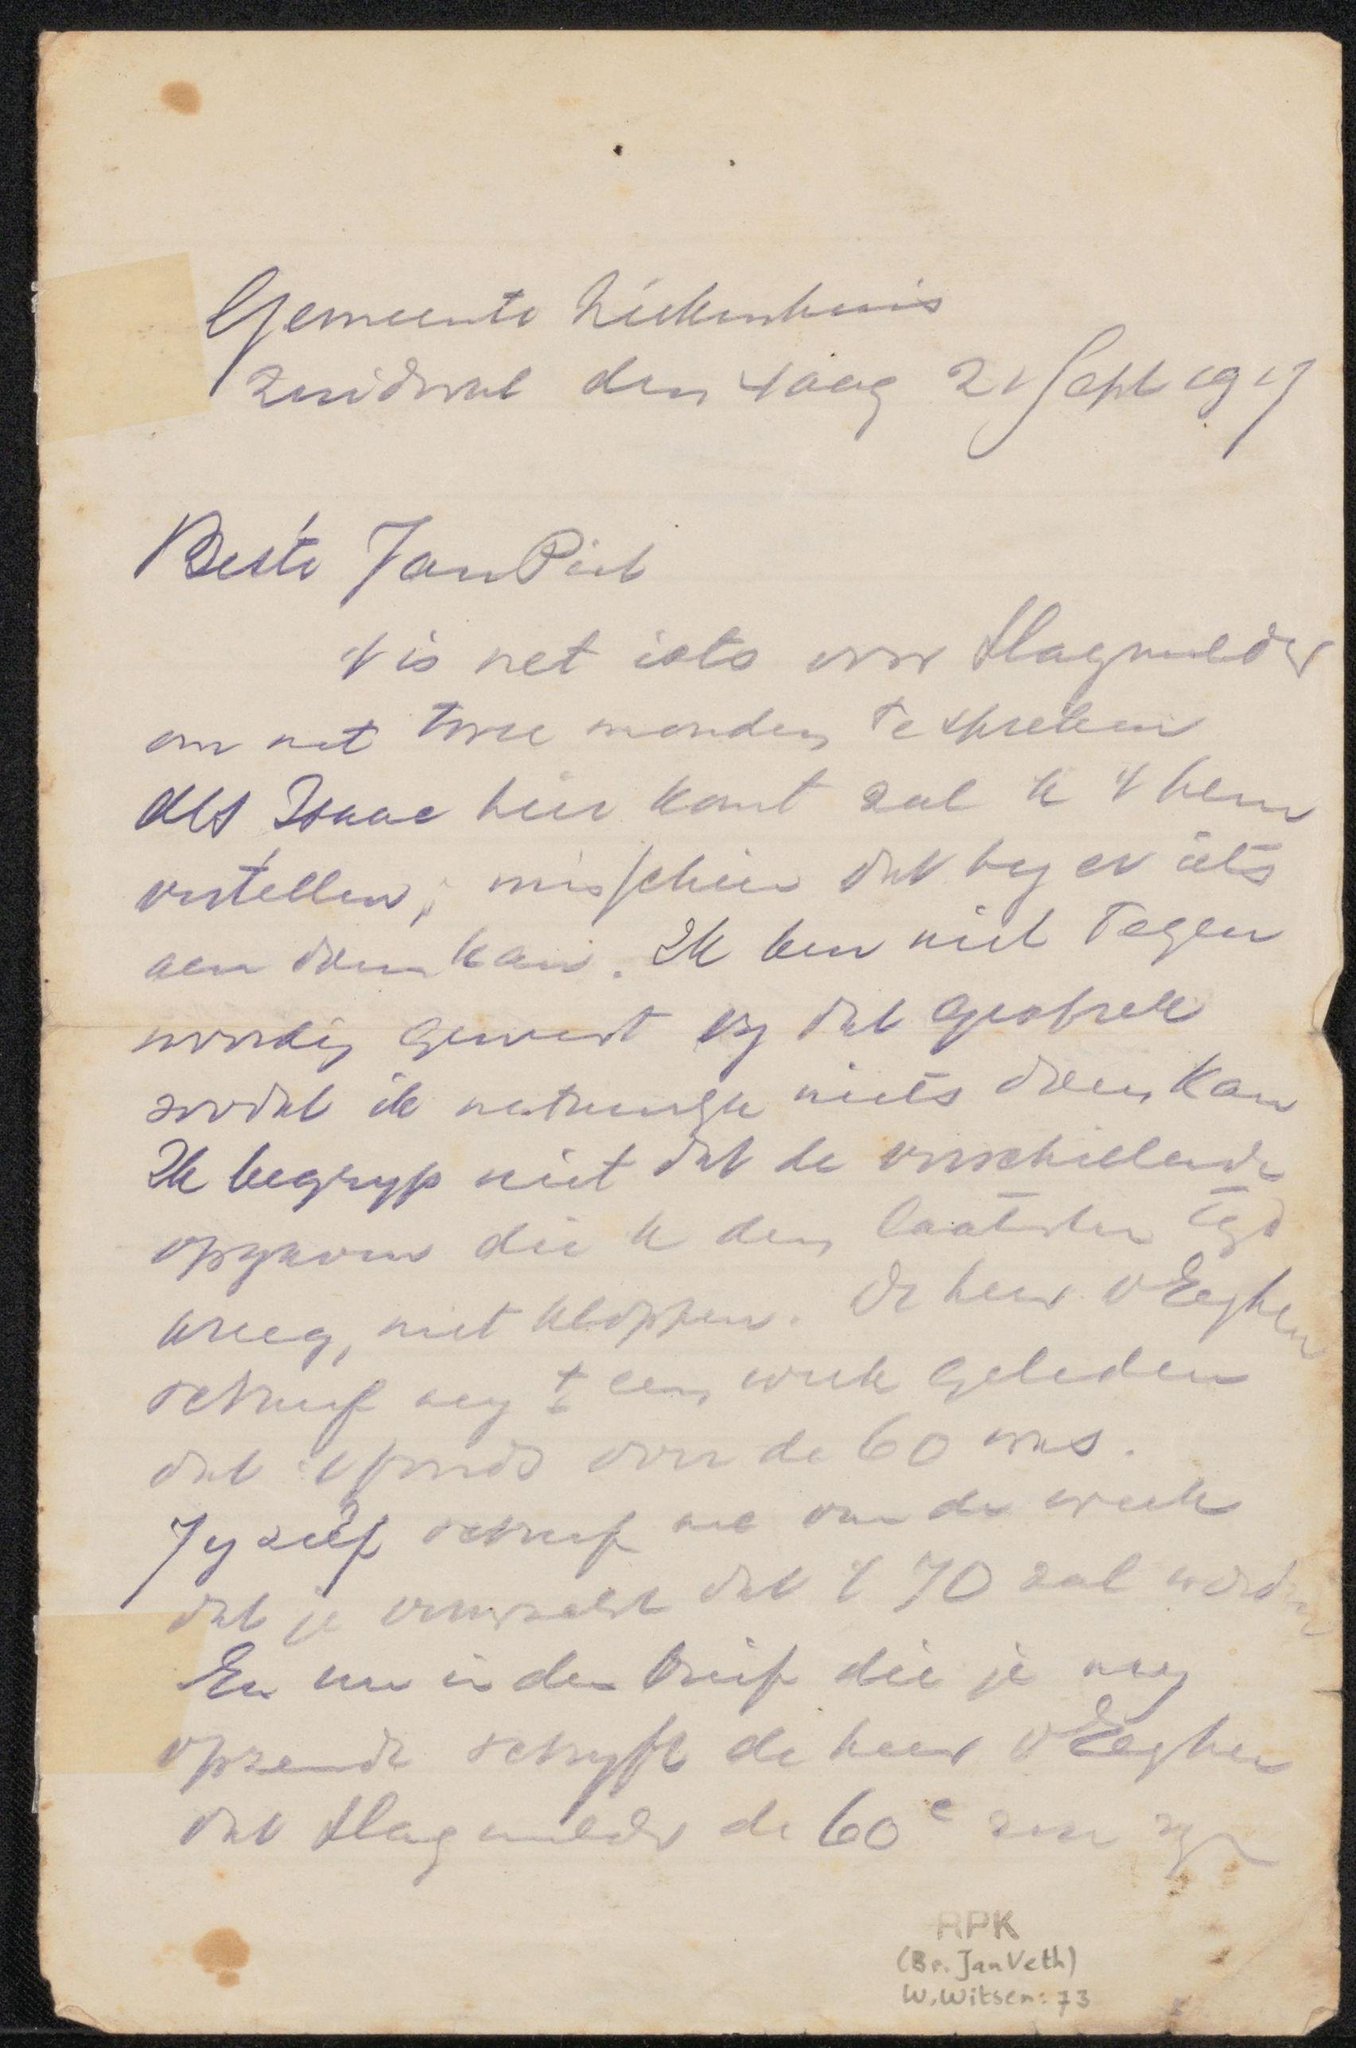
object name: letter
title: Brief aan Jan Veth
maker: willem witsen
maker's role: draughtsman, painter, print maker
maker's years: 1860-1923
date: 1917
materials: paper, pencil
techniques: writing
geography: the hague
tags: jacobus slagmulder, designer, jan veth, isaac israels, diseases, money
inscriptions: watermark, collector's mark: ‘RPK’